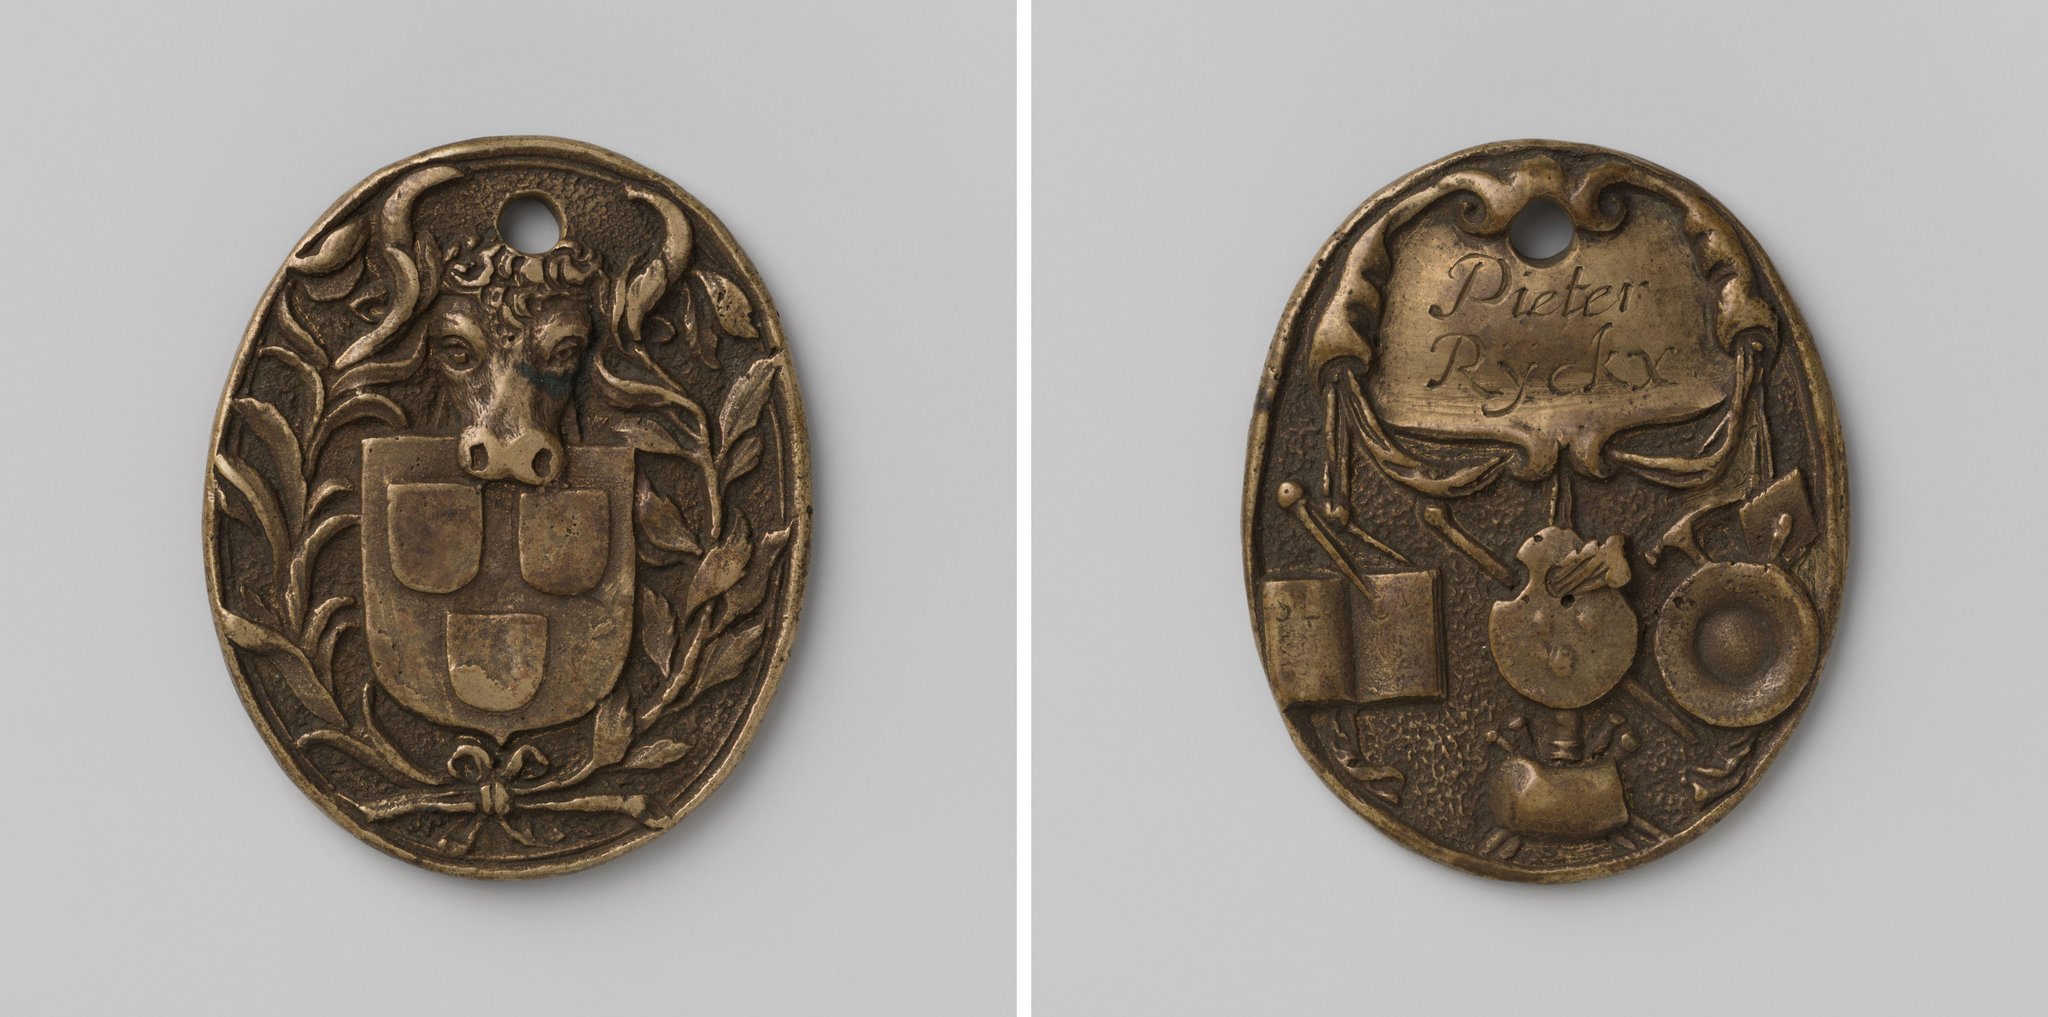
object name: medal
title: St. Lucas- of schilders- en konstwerkersgilde van Rotterdam, gildepenning van Pieter Ryckx, beeldhouwer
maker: Anonymous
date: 1666-1672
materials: brass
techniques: casting, engraving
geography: rotterdam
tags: rotterdam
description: Messing ovale penning met gat erin. Voorzijde: ossekop boven St. Lucasschild binnen lauwerkrans. Keerzijde: compartiment met opschrift boven schetsboek, paneel, schotel, passer, beeldhouwershamer etc.